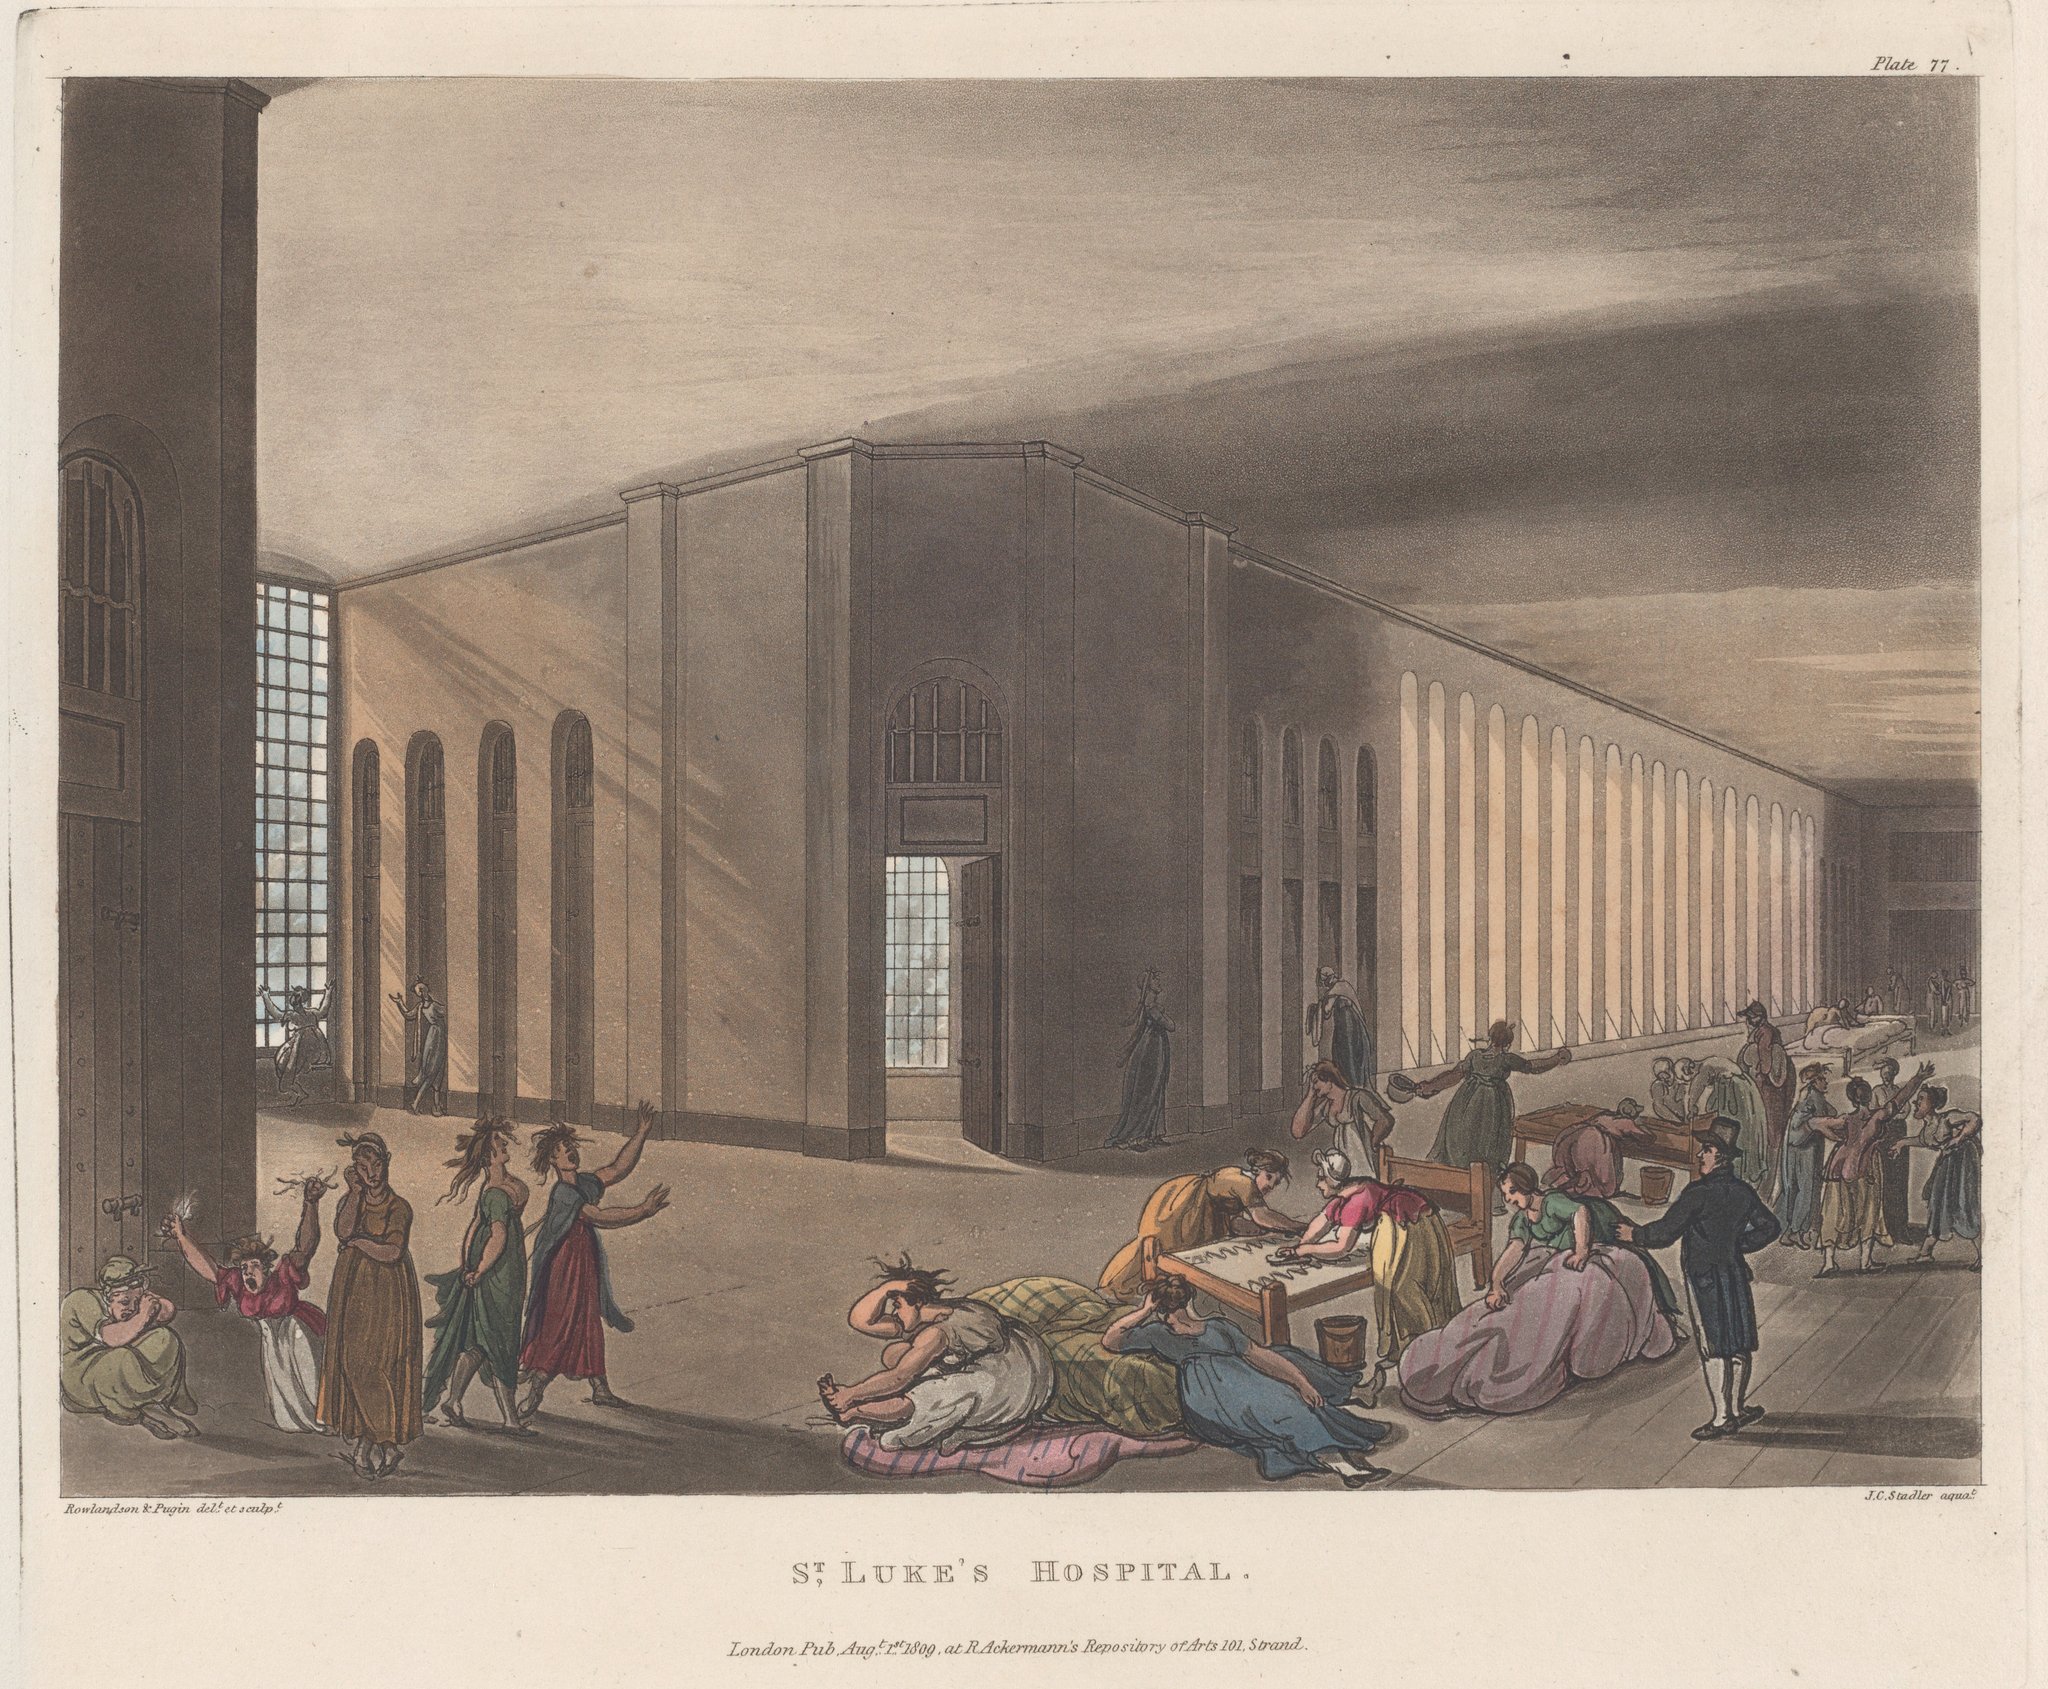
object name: print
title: St Luke's Hospital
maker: thomas rowlandson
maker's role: artist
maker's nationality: british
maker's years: 1757-1827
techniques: aquatint, etching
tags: hospitals,interiors,illness,men,women